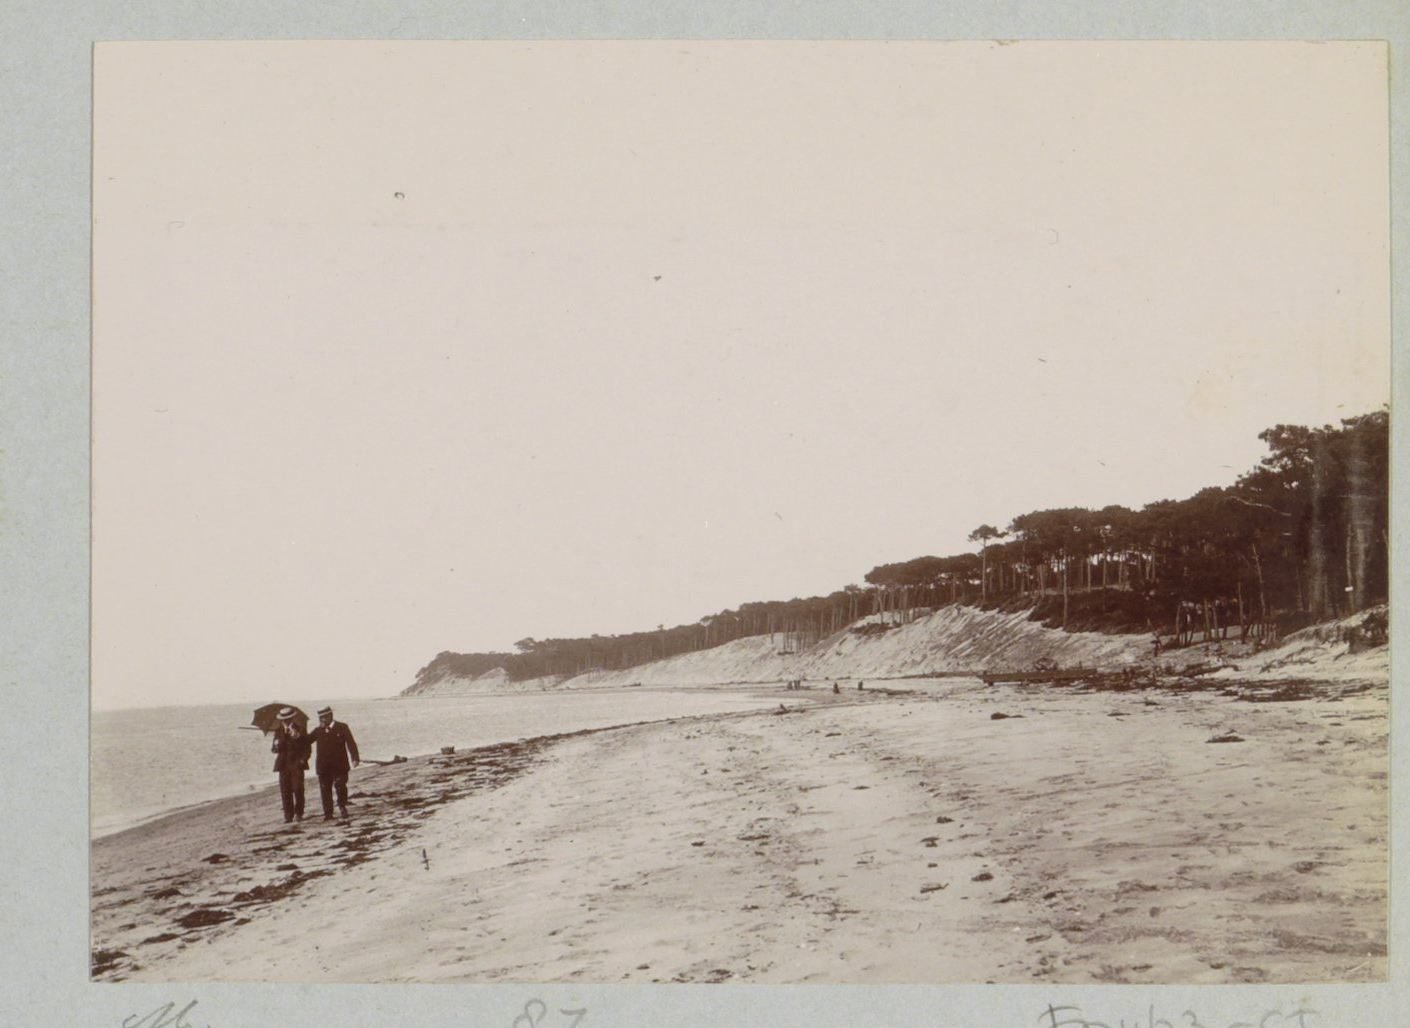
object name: photograph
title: Twee mannen aan het strand te Le Moulleau bij Arcachon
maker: delizy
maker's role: manufacturer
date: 1803-1897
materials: paper, photographic support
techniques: gelatin silver print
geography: arcachon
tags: walking, hiking (recreation), beach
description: Onderdeel van Fotoalbum van een Franse amateurfotograaf met opnames van uitstapjes in Frankrijk, Spanje, België, Luxemburg en Nederland, de eerste automobielen en autoraces.